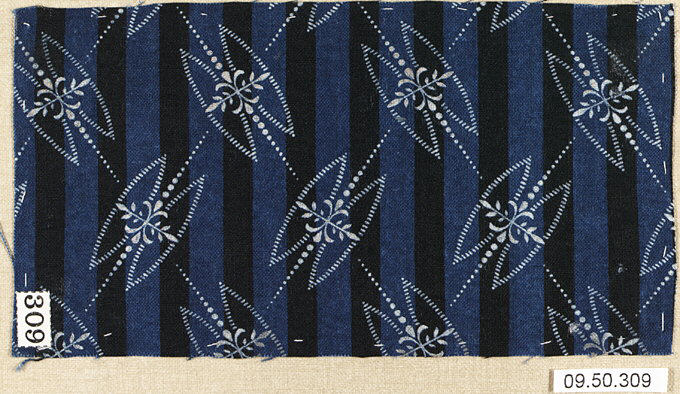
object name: piece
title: Piece (one of 116)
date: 1801-1900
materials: cotton